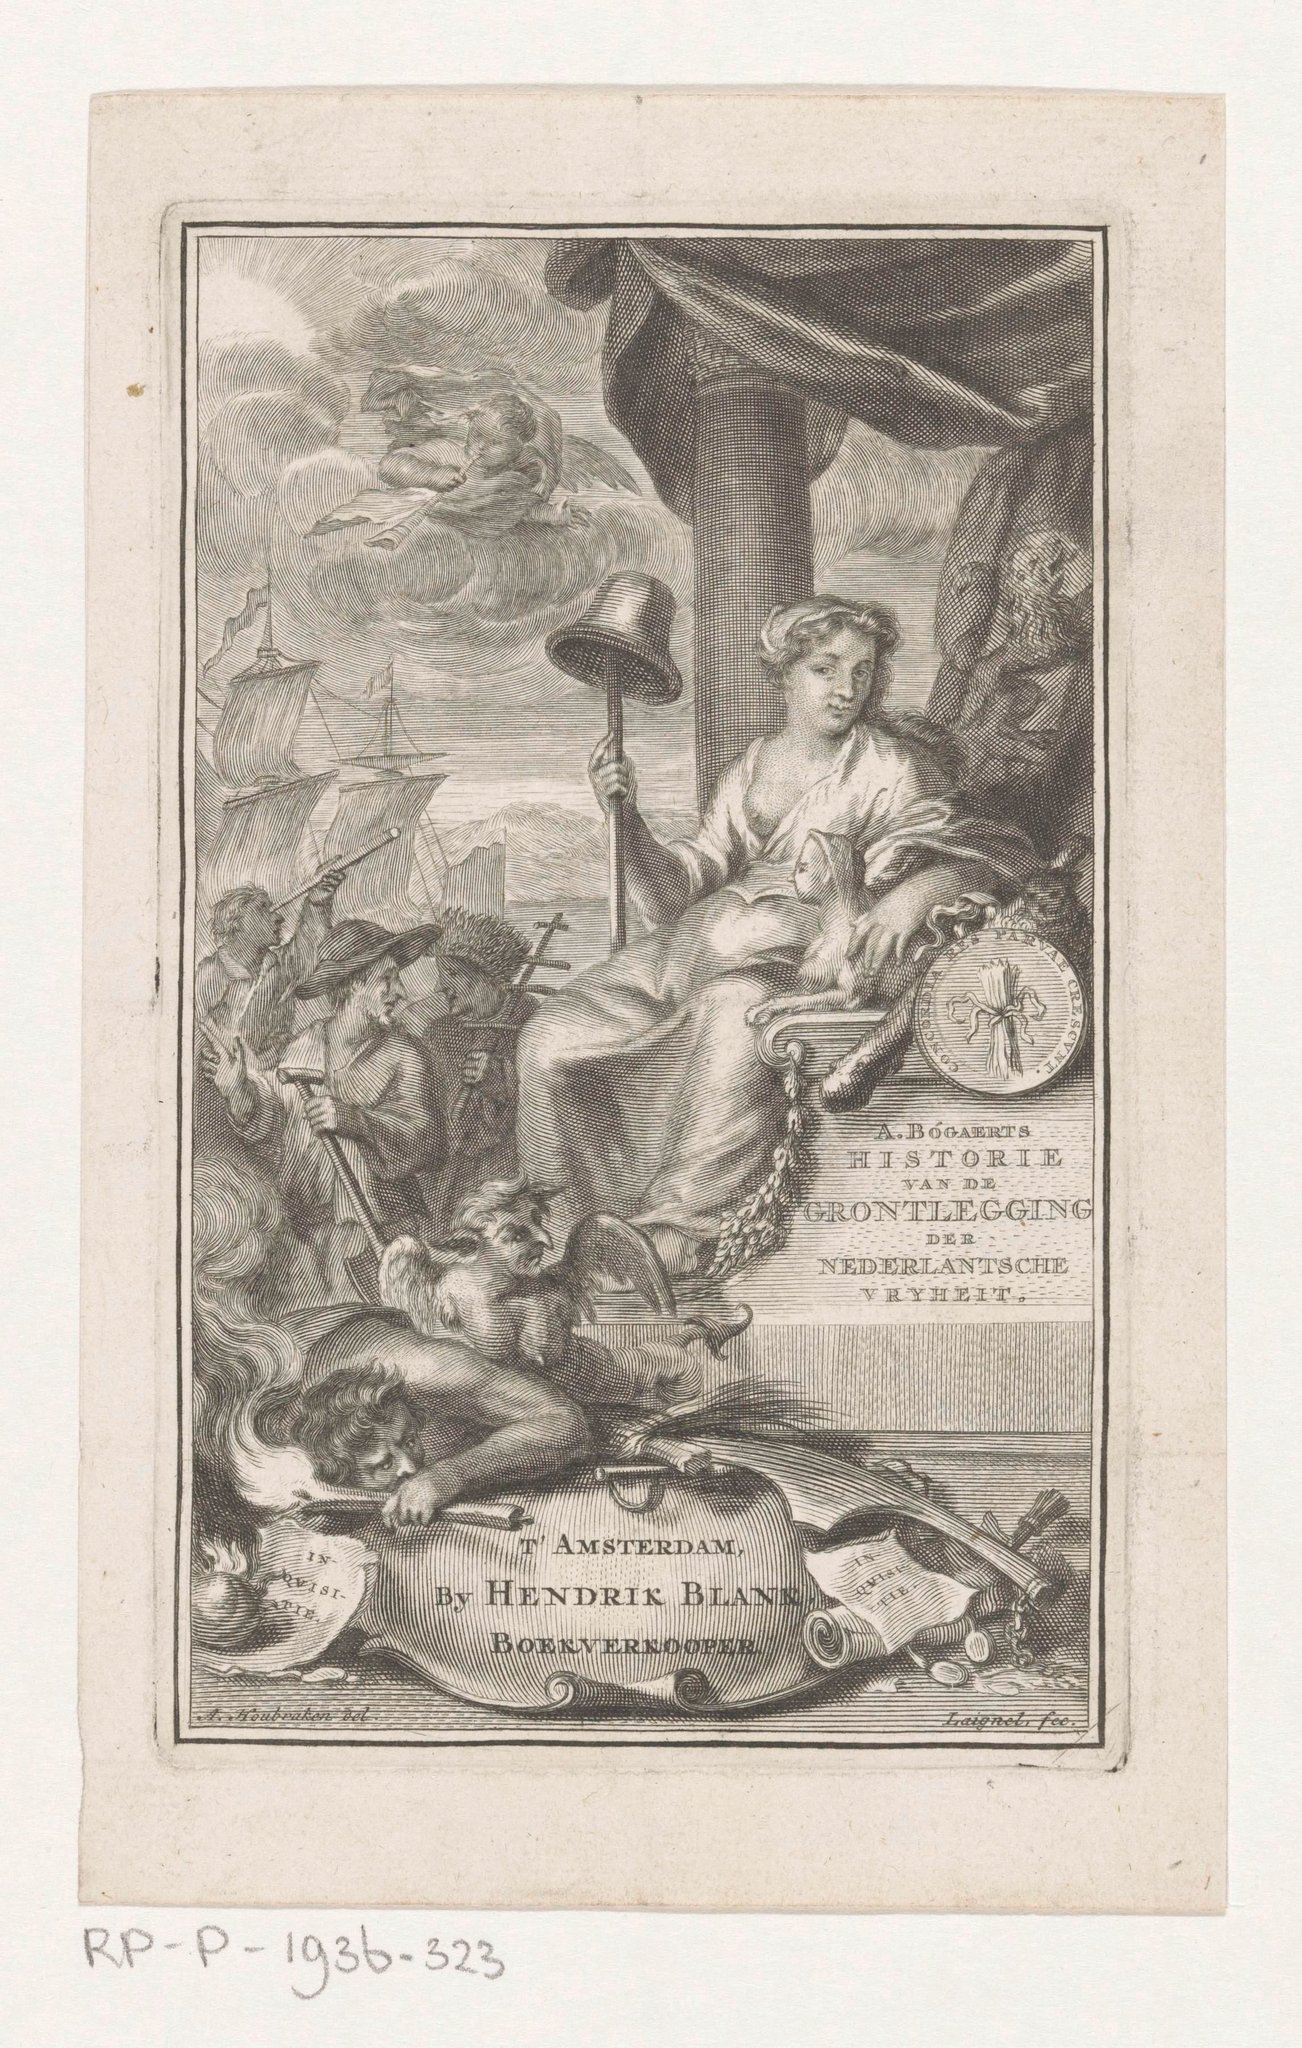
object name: titelblad, titelpagina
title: Titelpagina voor: Abraham Bogaerts, Historie van de grontlegging der Nederlandsche Vryheit, 1716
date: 1716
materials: paper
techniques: engraving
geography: amsterdam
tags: personifications of countries, nations, states, districts, etc., freedom, liberty; 'libertà' (ripa)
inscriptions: collector's mark: Lugt 2228, collector's mark: Lugt 2760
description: De Hollandse maagd met vrijheidshoed, sfinx, knots en medaille zit op een troon met boektitel. Zij personifieert de vrijheid. Achter haar een draperie met de Hollandse leeuw. Bij haar voeten personificaties van haat en oorlog en brieven met Inquisitie. Naast haar staat een boer met spade en twee zeelieden met verrekijker en jakobsstaf. Daarachter schepen en in de wolken Faam blazend op een bazuin.